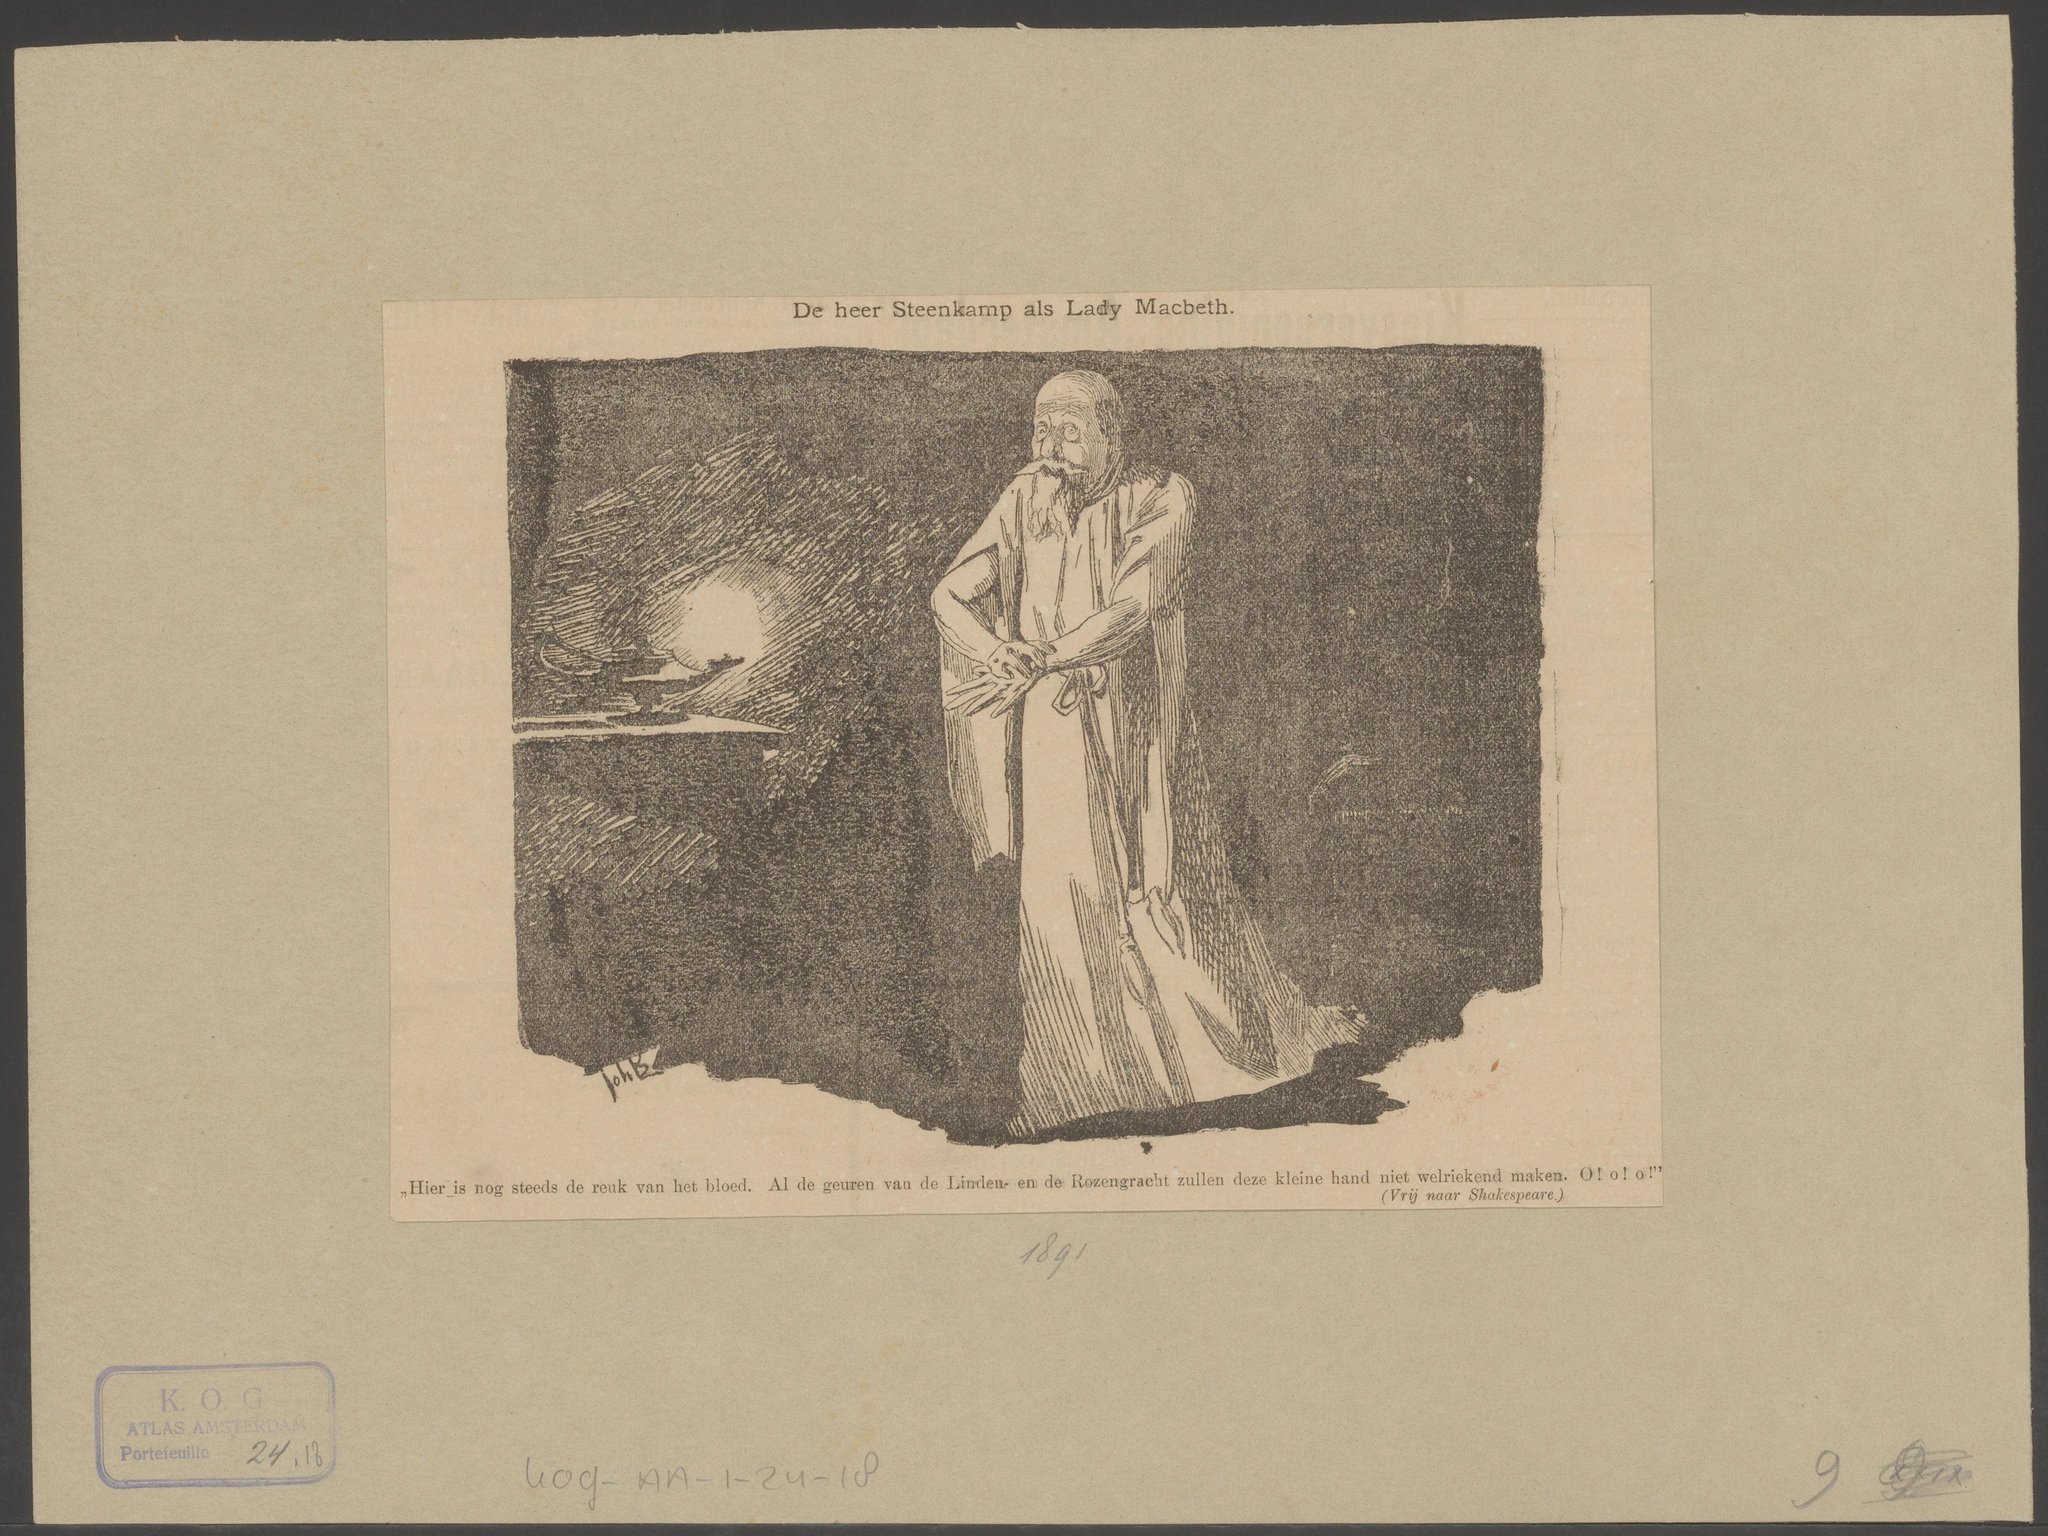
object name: cartoon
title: De heer Steenkamp als Lady Macbeth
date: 1891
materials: paper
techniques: letterpress printing, line block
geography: amsterdam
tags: lady macbeth, political caricatures and satires, amsterdam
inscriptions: collector's mark: Lugt 1641b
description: Prent uit: De Amsterdammer 15 (1891), nr. 734, 19 juli 1891, p. 7.